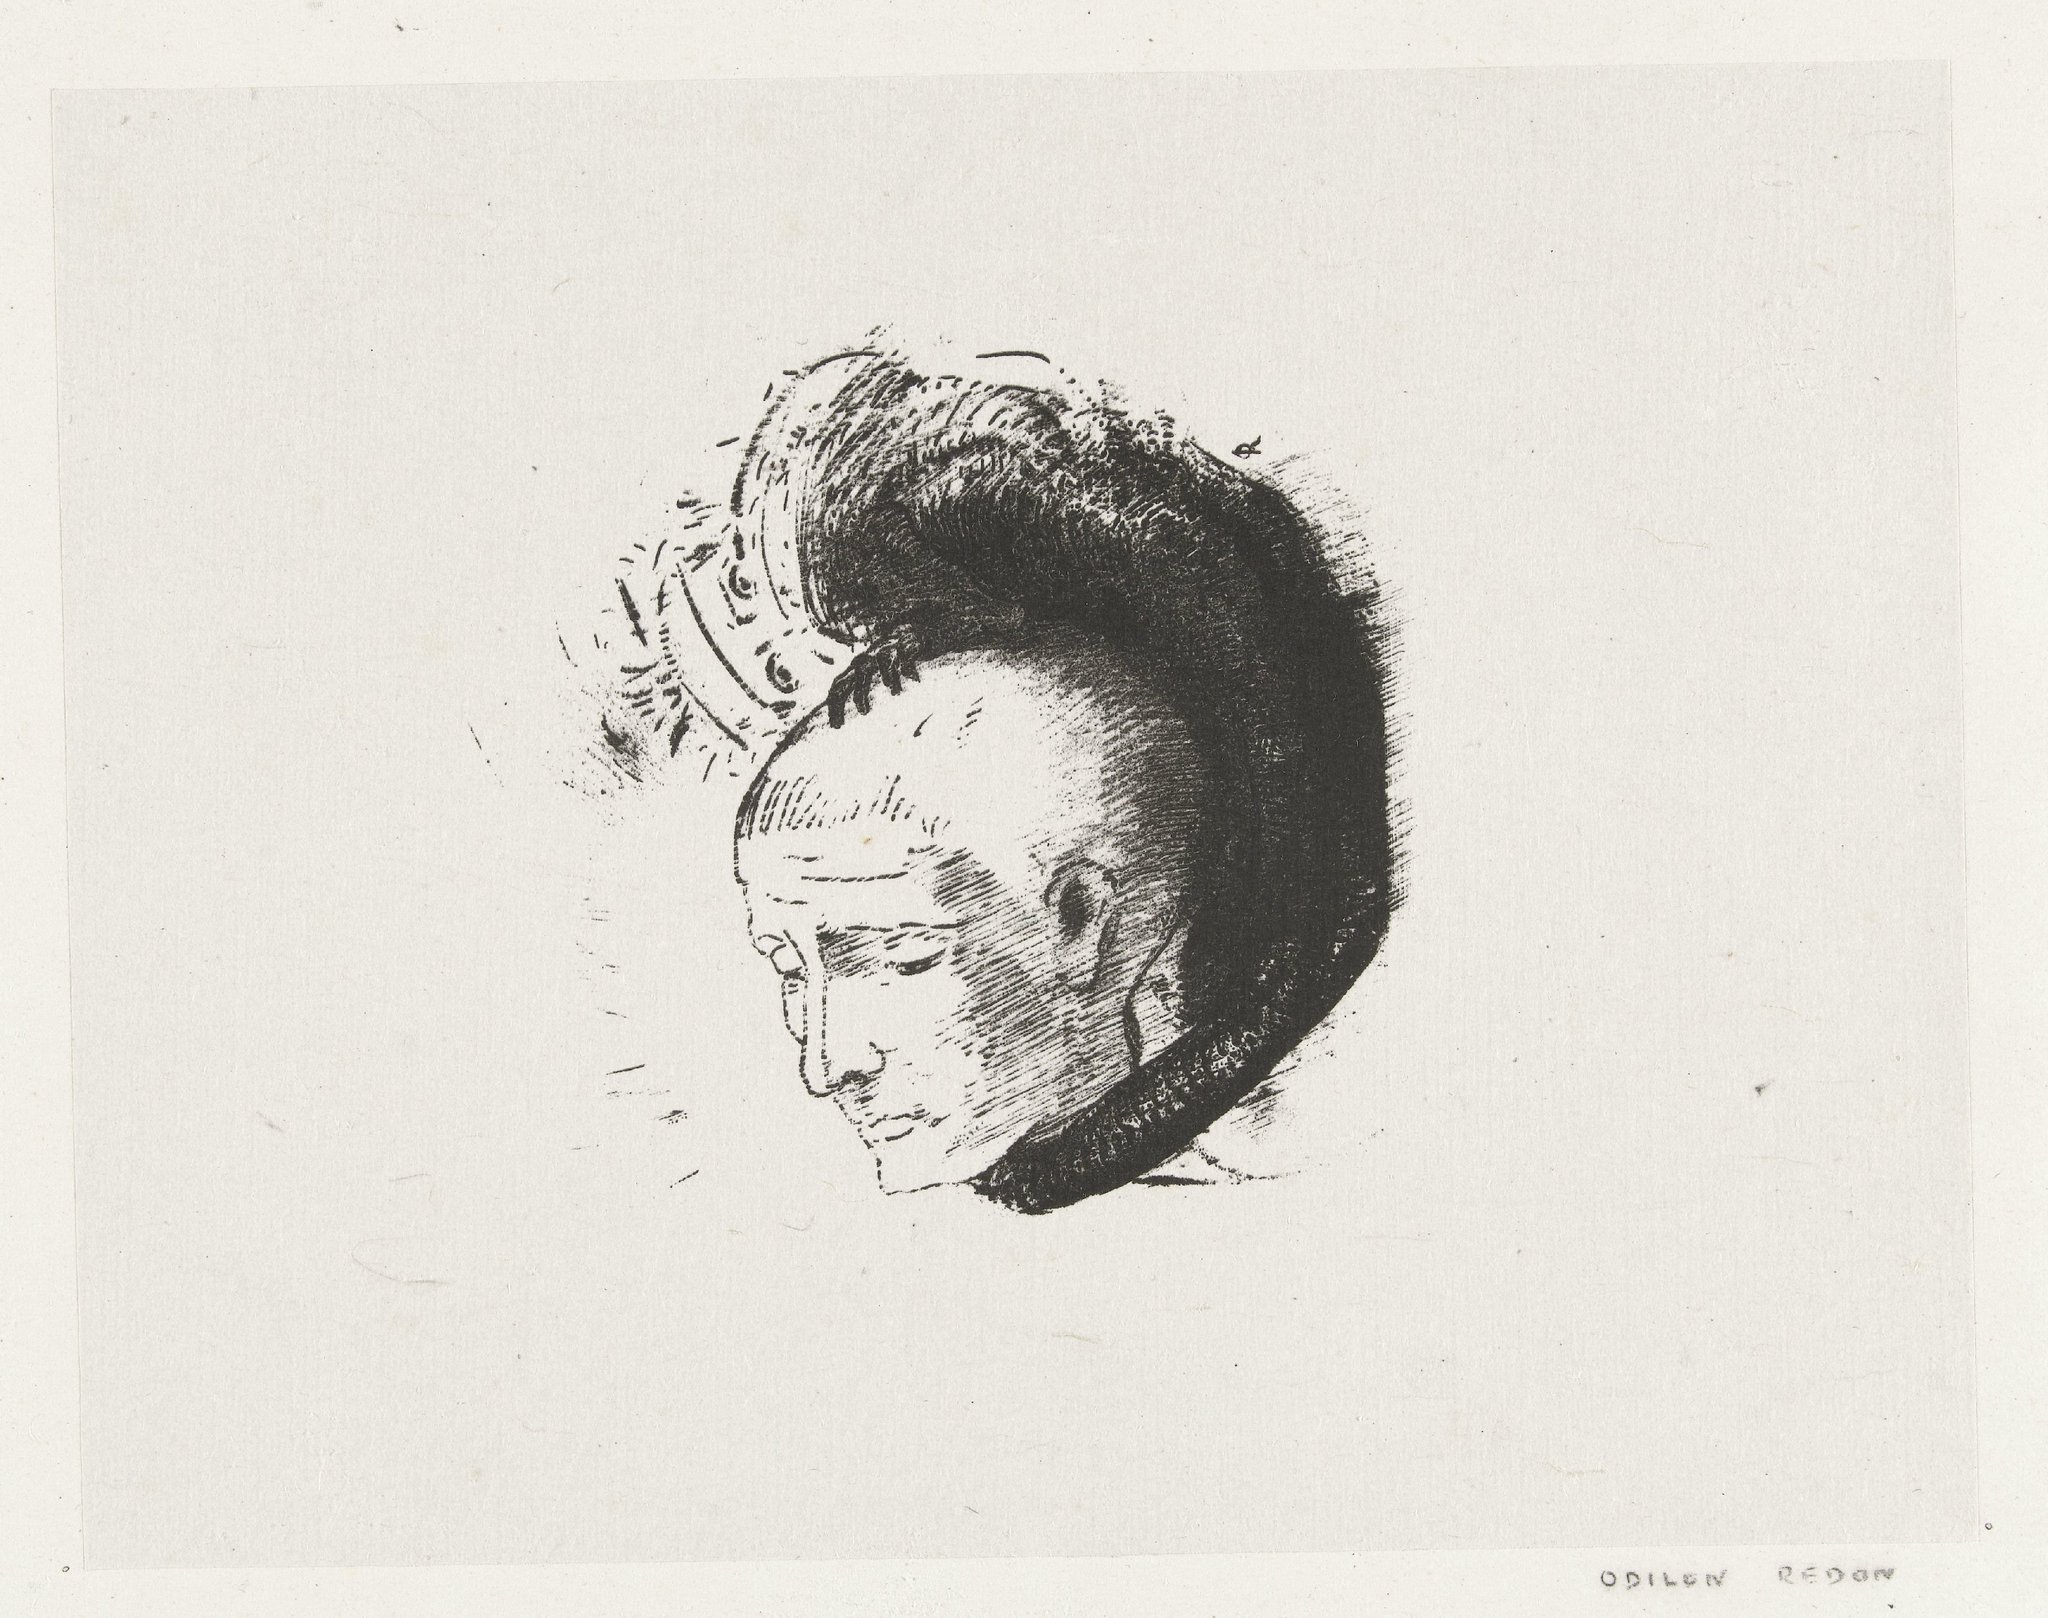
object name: print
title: De idealistische beweging in de schilderkunst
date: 1896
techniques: printmaking, lithograph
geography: paris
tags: head (human), fabulous animals ~ reptiles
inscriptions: collector's mark: Lugt 2228, collector's mark: Lugt 2760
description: Prent is oorspronkelijk gemaakt als illustratie voor André Mellerio's boek "Le mouvement idéalist en peinture", uit 1896. Deze afdruk van de prent is door Redon laten maken buiten de editie van het boek om. K. Botke